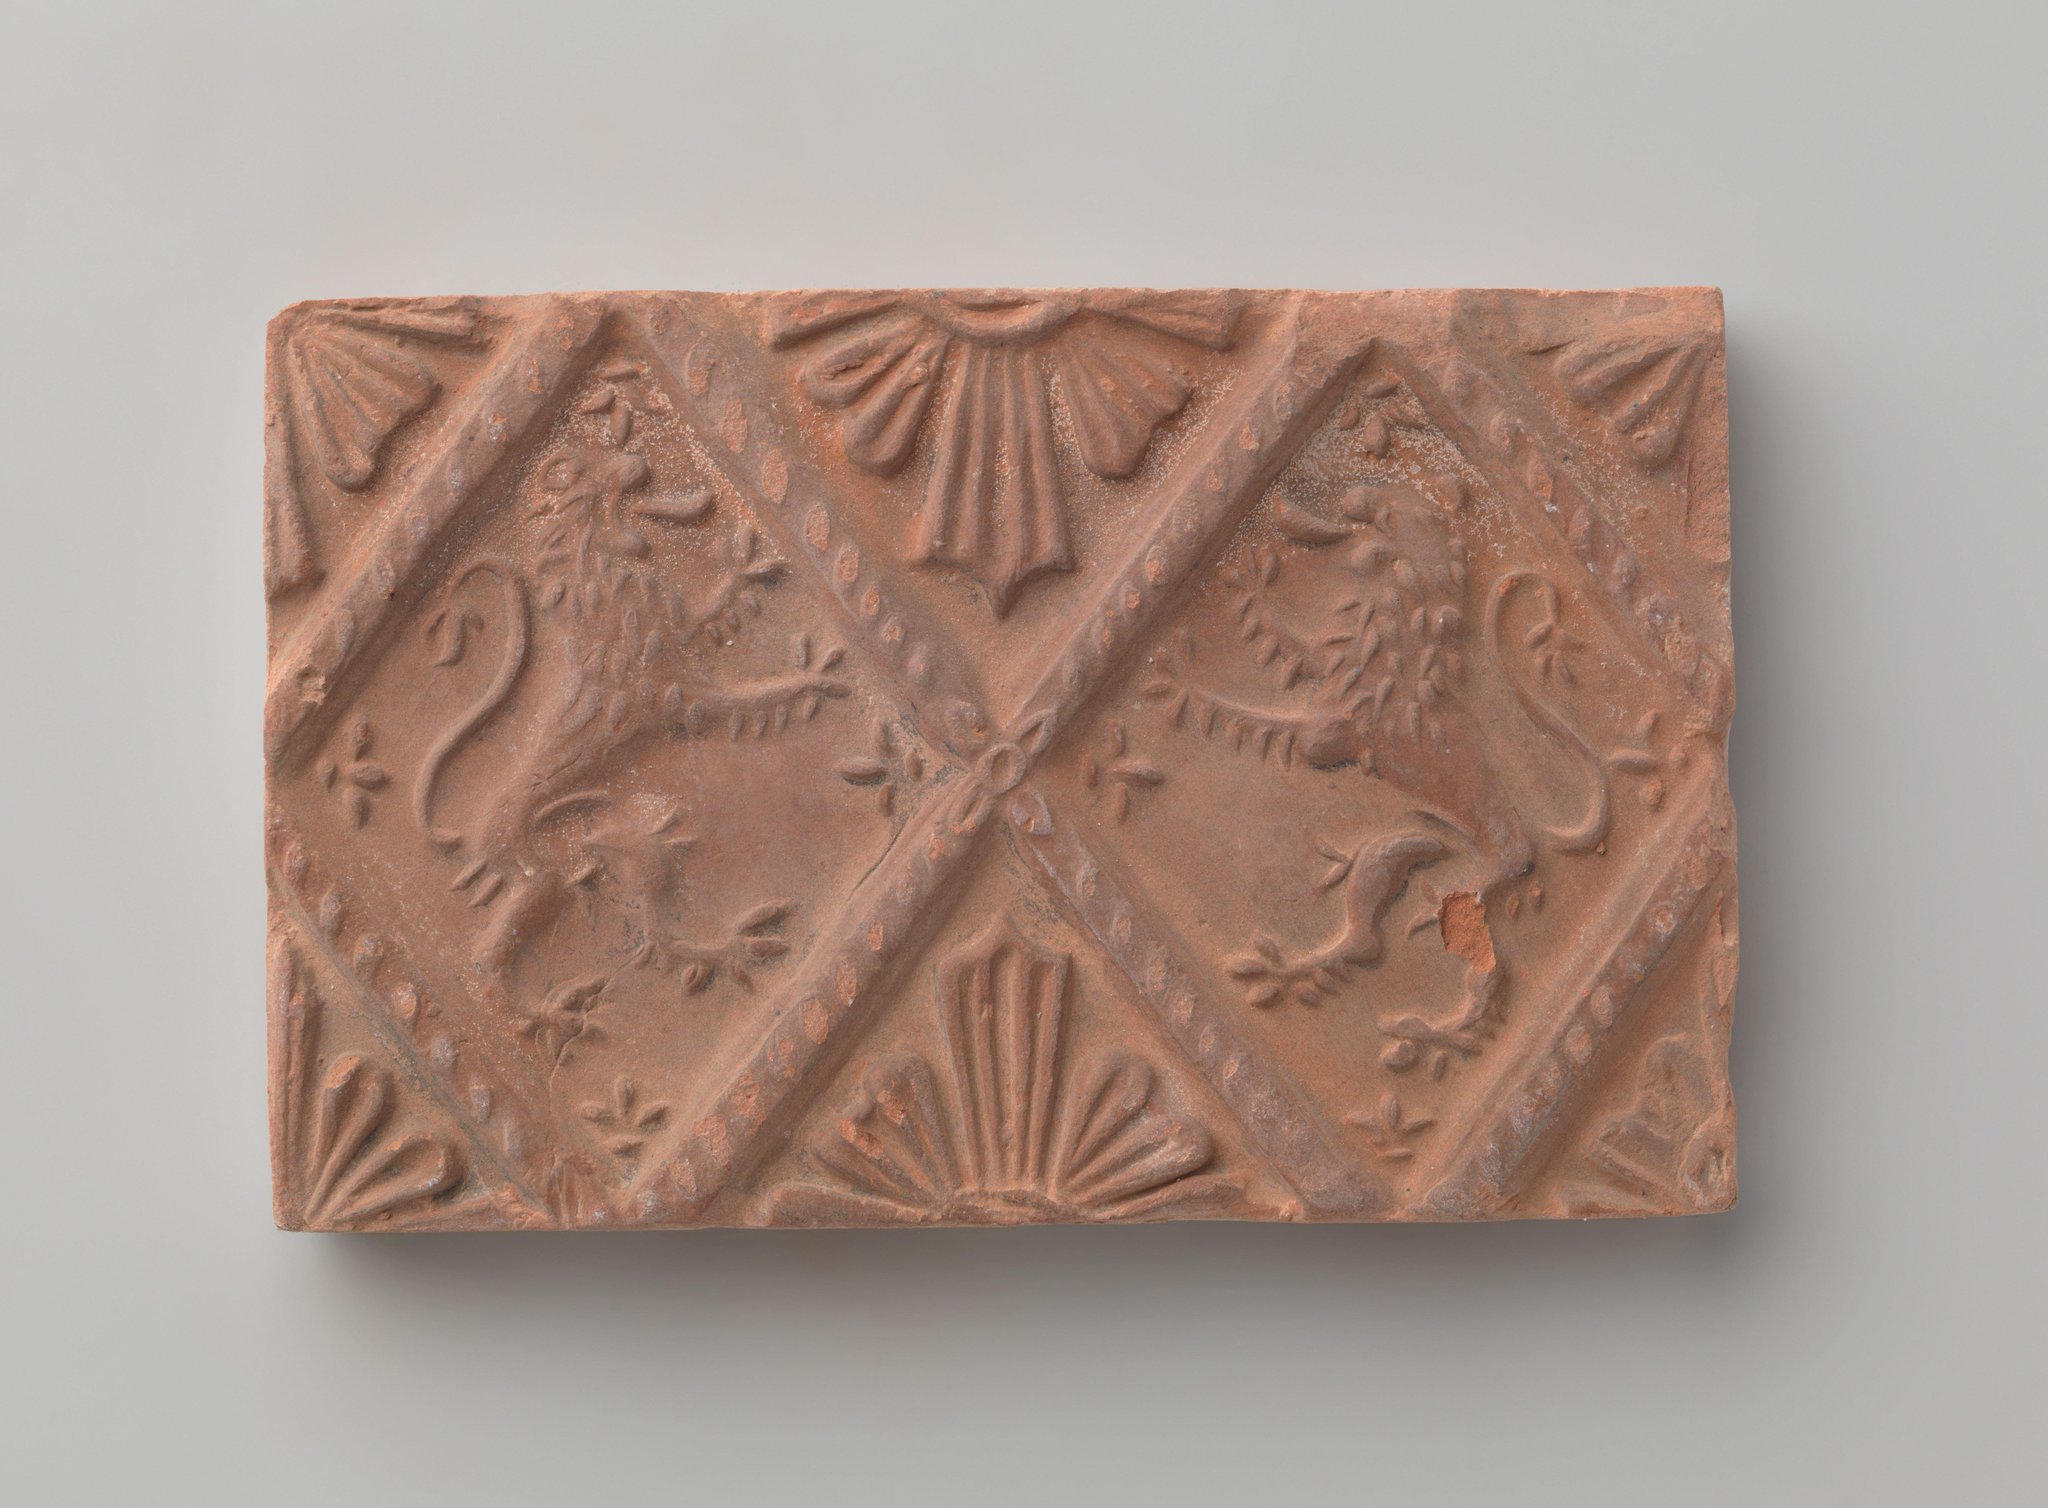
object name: hearthstone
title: Haardsteen met voorstelling van twee klimmende leeuwen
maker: Anonymous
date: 1875-1900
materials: earthenware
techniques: printing, firing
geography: netherlands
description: Haardsteen met voorstelling van twee klimmende leeuwen, geplaatst in geprofileerde ruit. De halve ruiten aan de boven- en onderkant zijn opgevuld met stermotief.